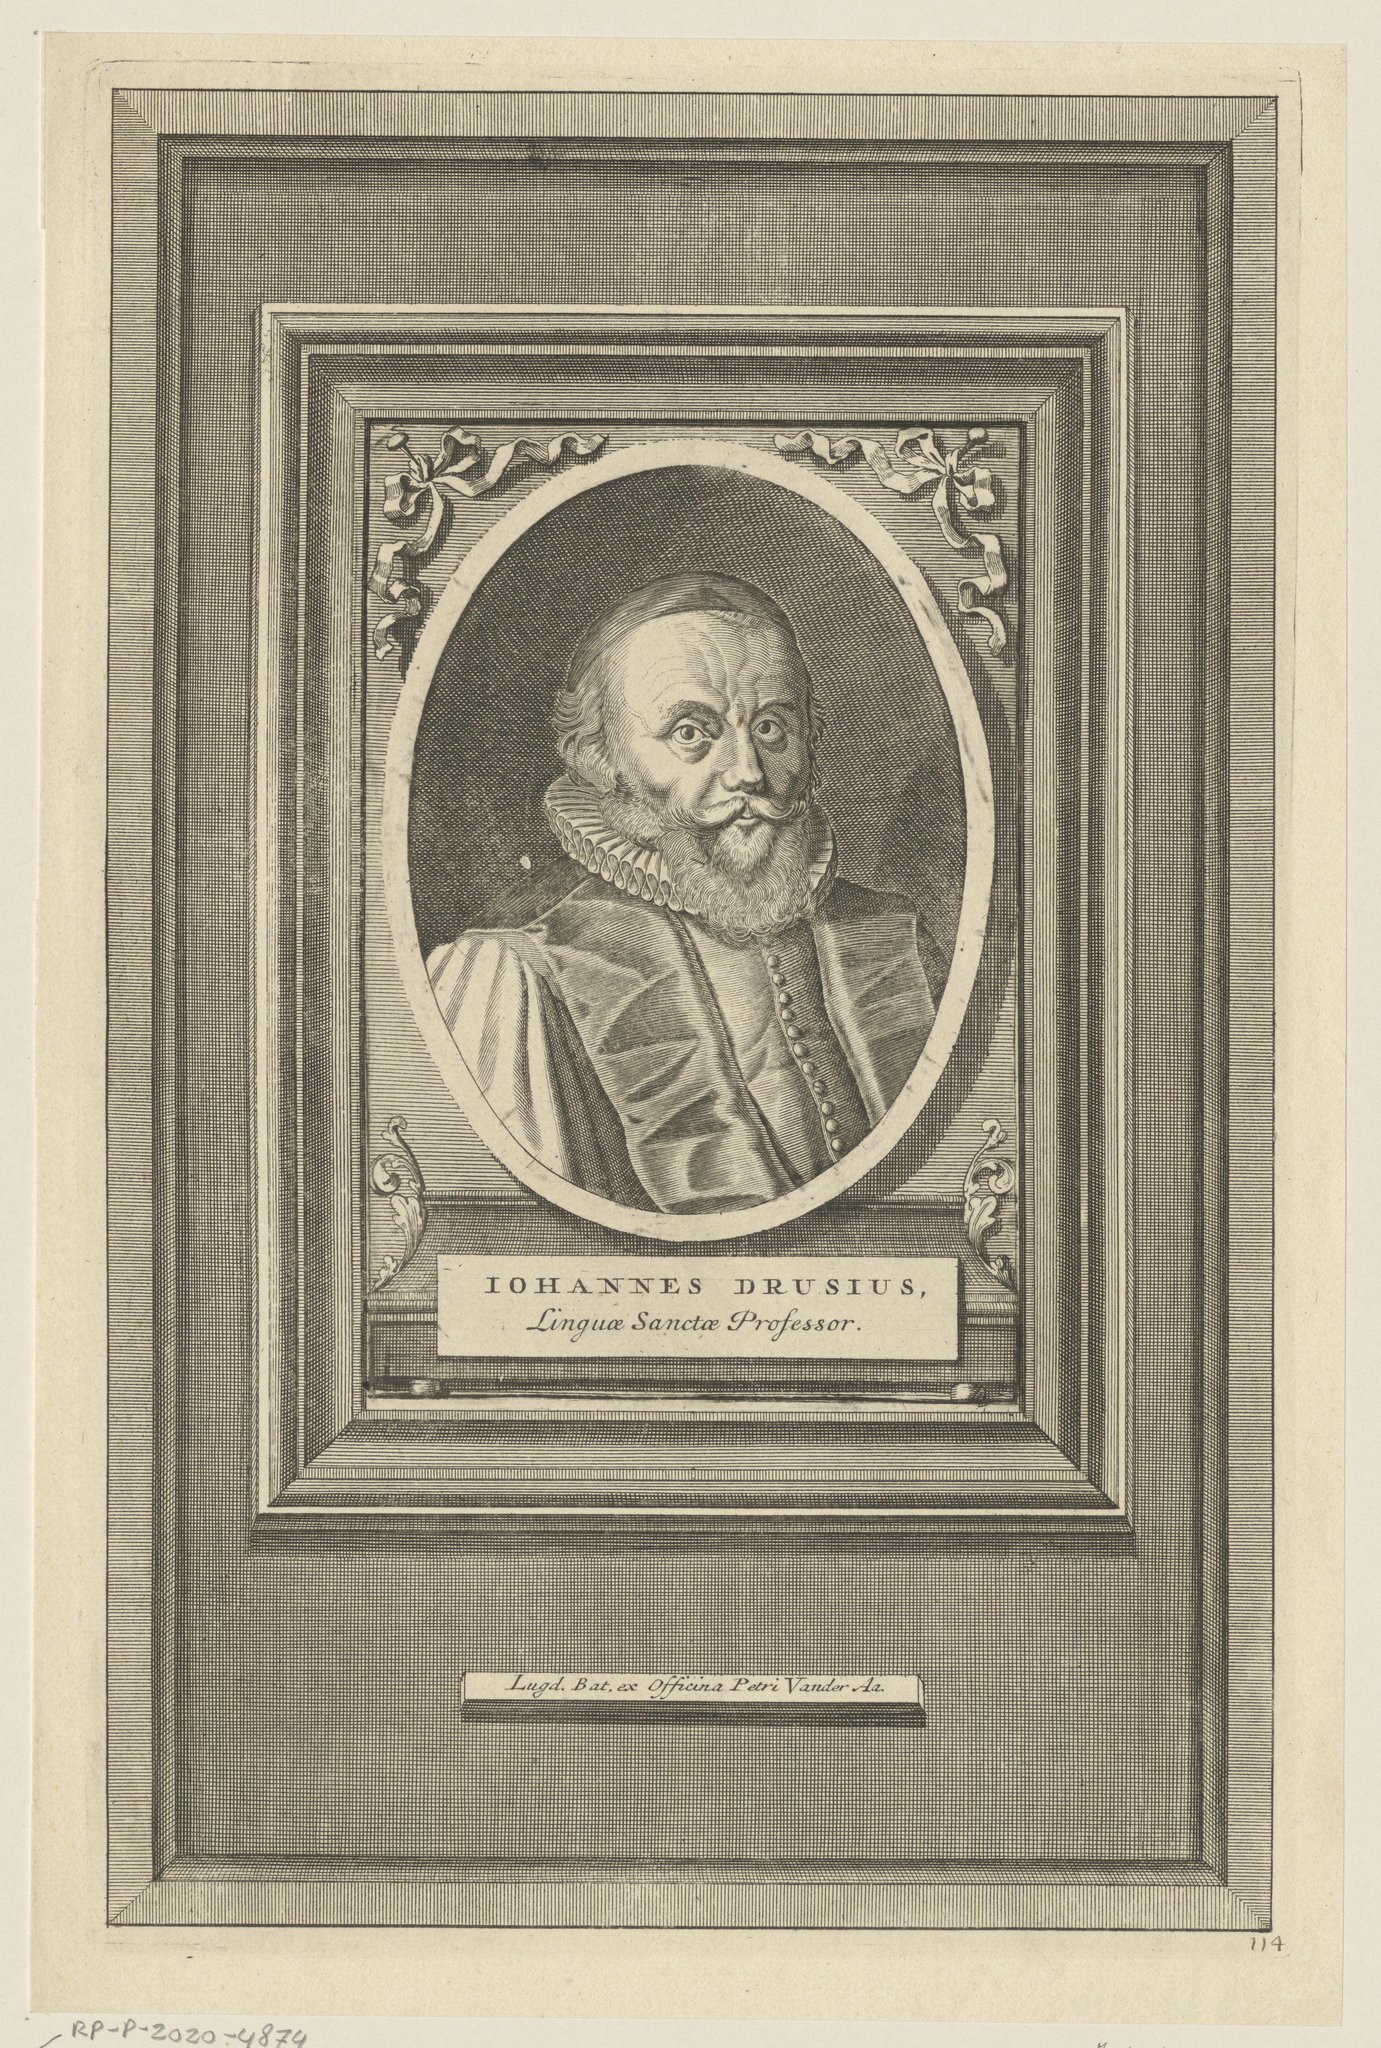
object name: print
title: Portret van Johannes van den Driesche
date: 1716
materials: paper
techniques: engraving, etching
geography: leiden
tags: theologian, historical persons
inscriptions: inscription: ‘114’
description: Prent mogelijk uit: Fundatoris curatorum et professorum celeberrimorum, (...) academia Lugduno-Batava (...). Leiden: Pieter van der Aa, [ca. 1716].